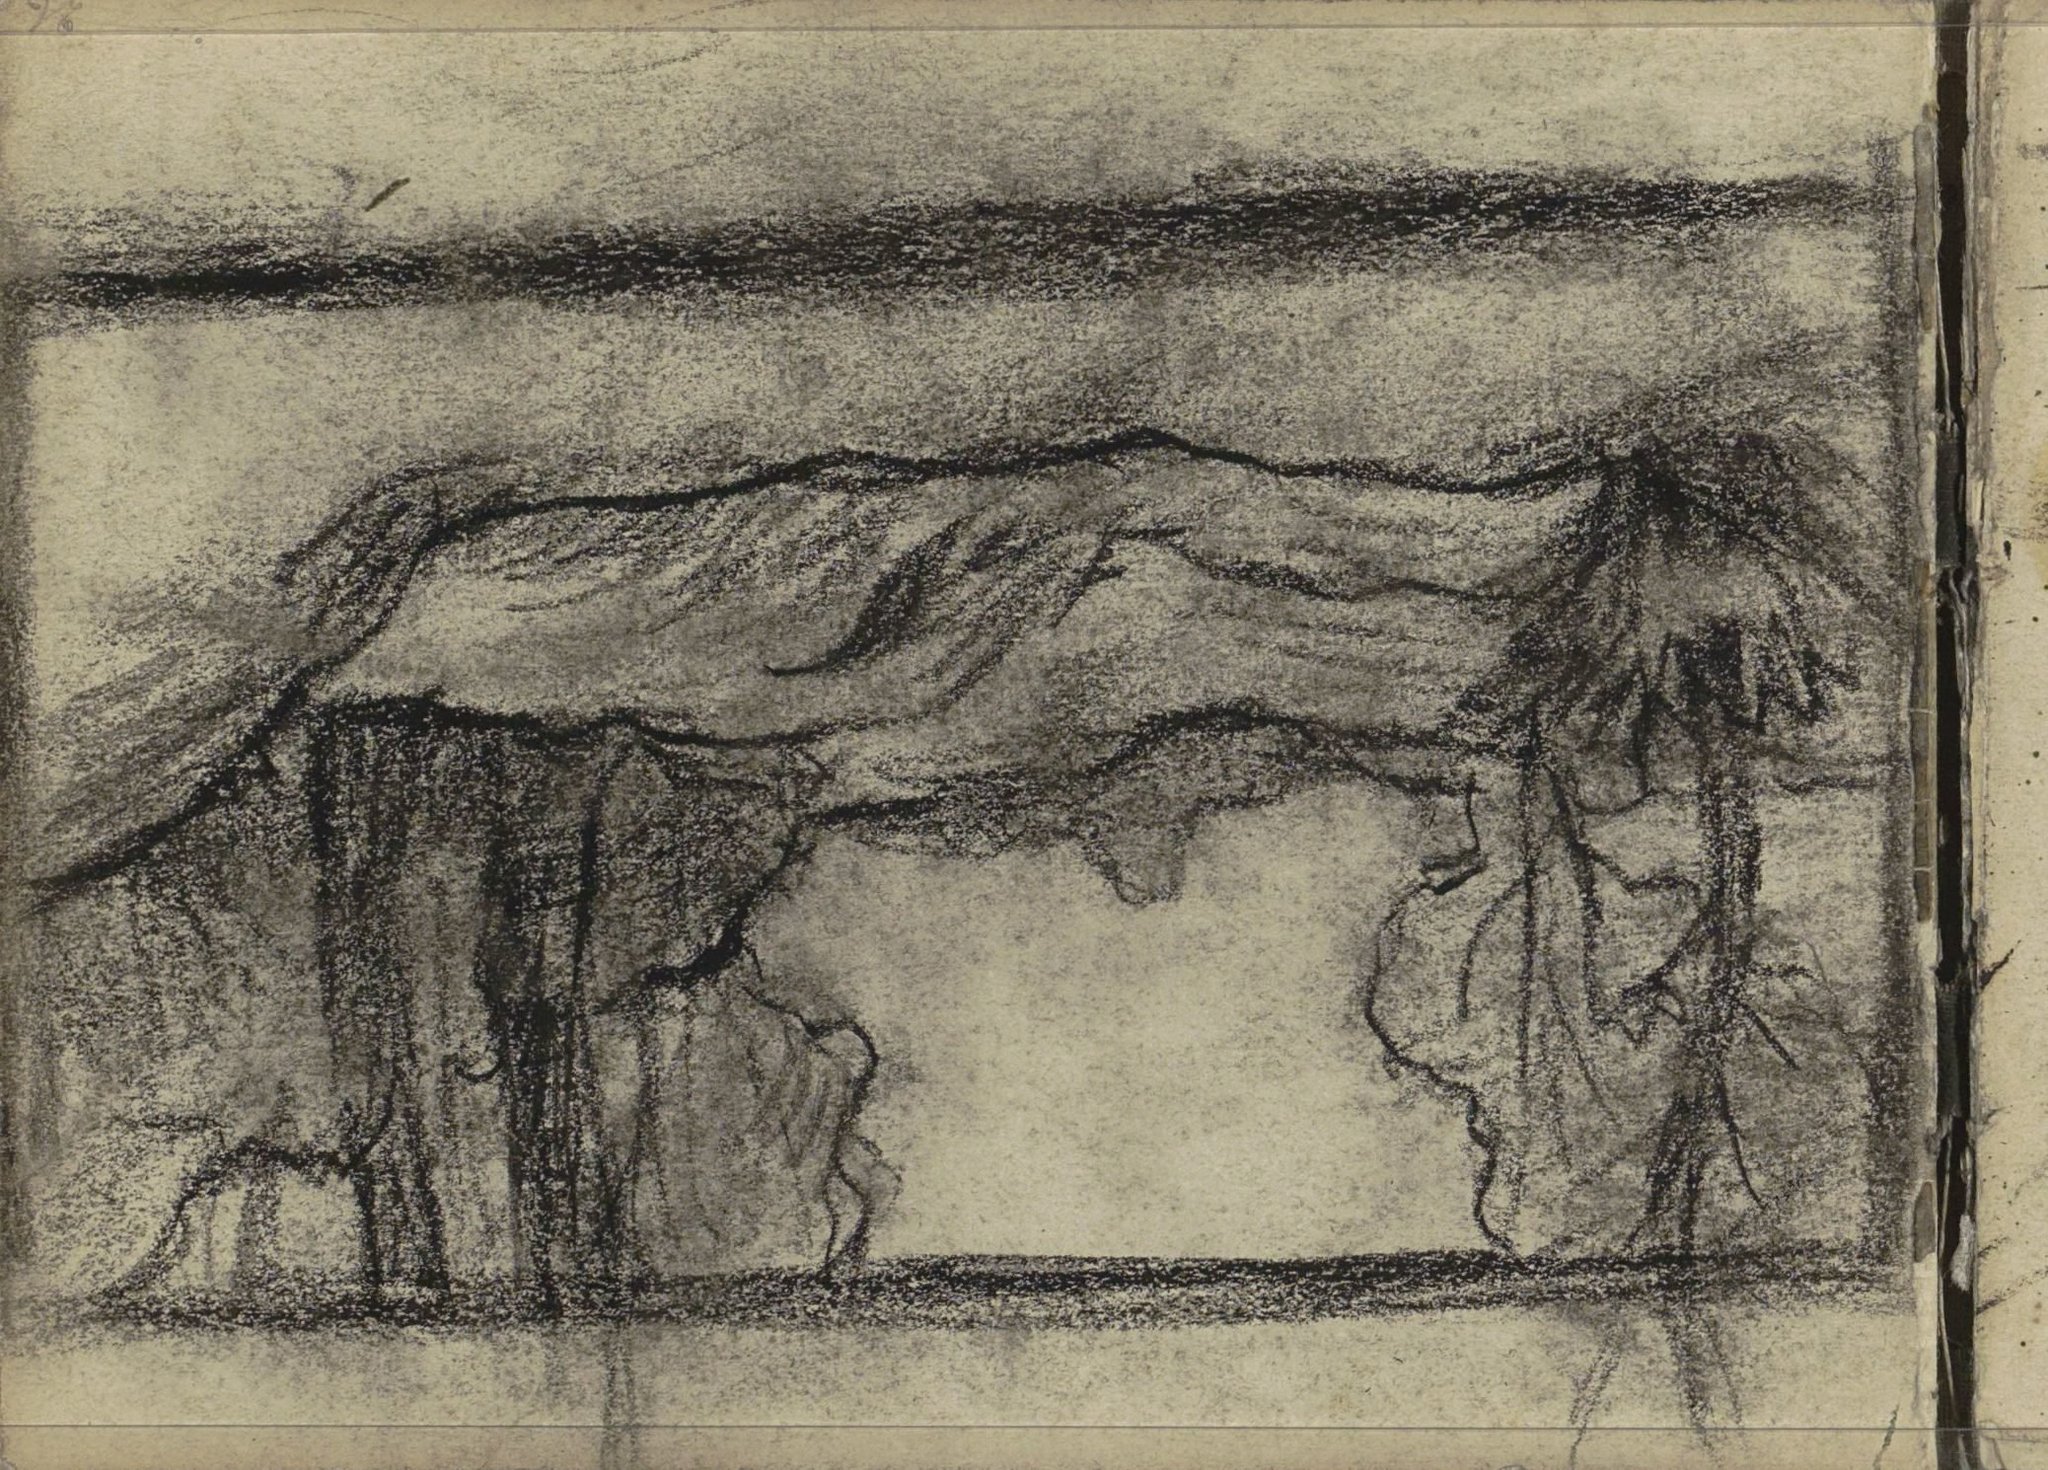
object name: sketchbook leaf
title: Heuvellandschap met bomen en struiken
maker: hermannus adrianus van oosterzee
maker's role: draughtsman, painter, print maker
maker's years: 1863-1933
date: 1893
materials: charcoal, paper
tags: low hill country, trees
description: Blad 21 verso uit een schetsboek met 23 bladen.